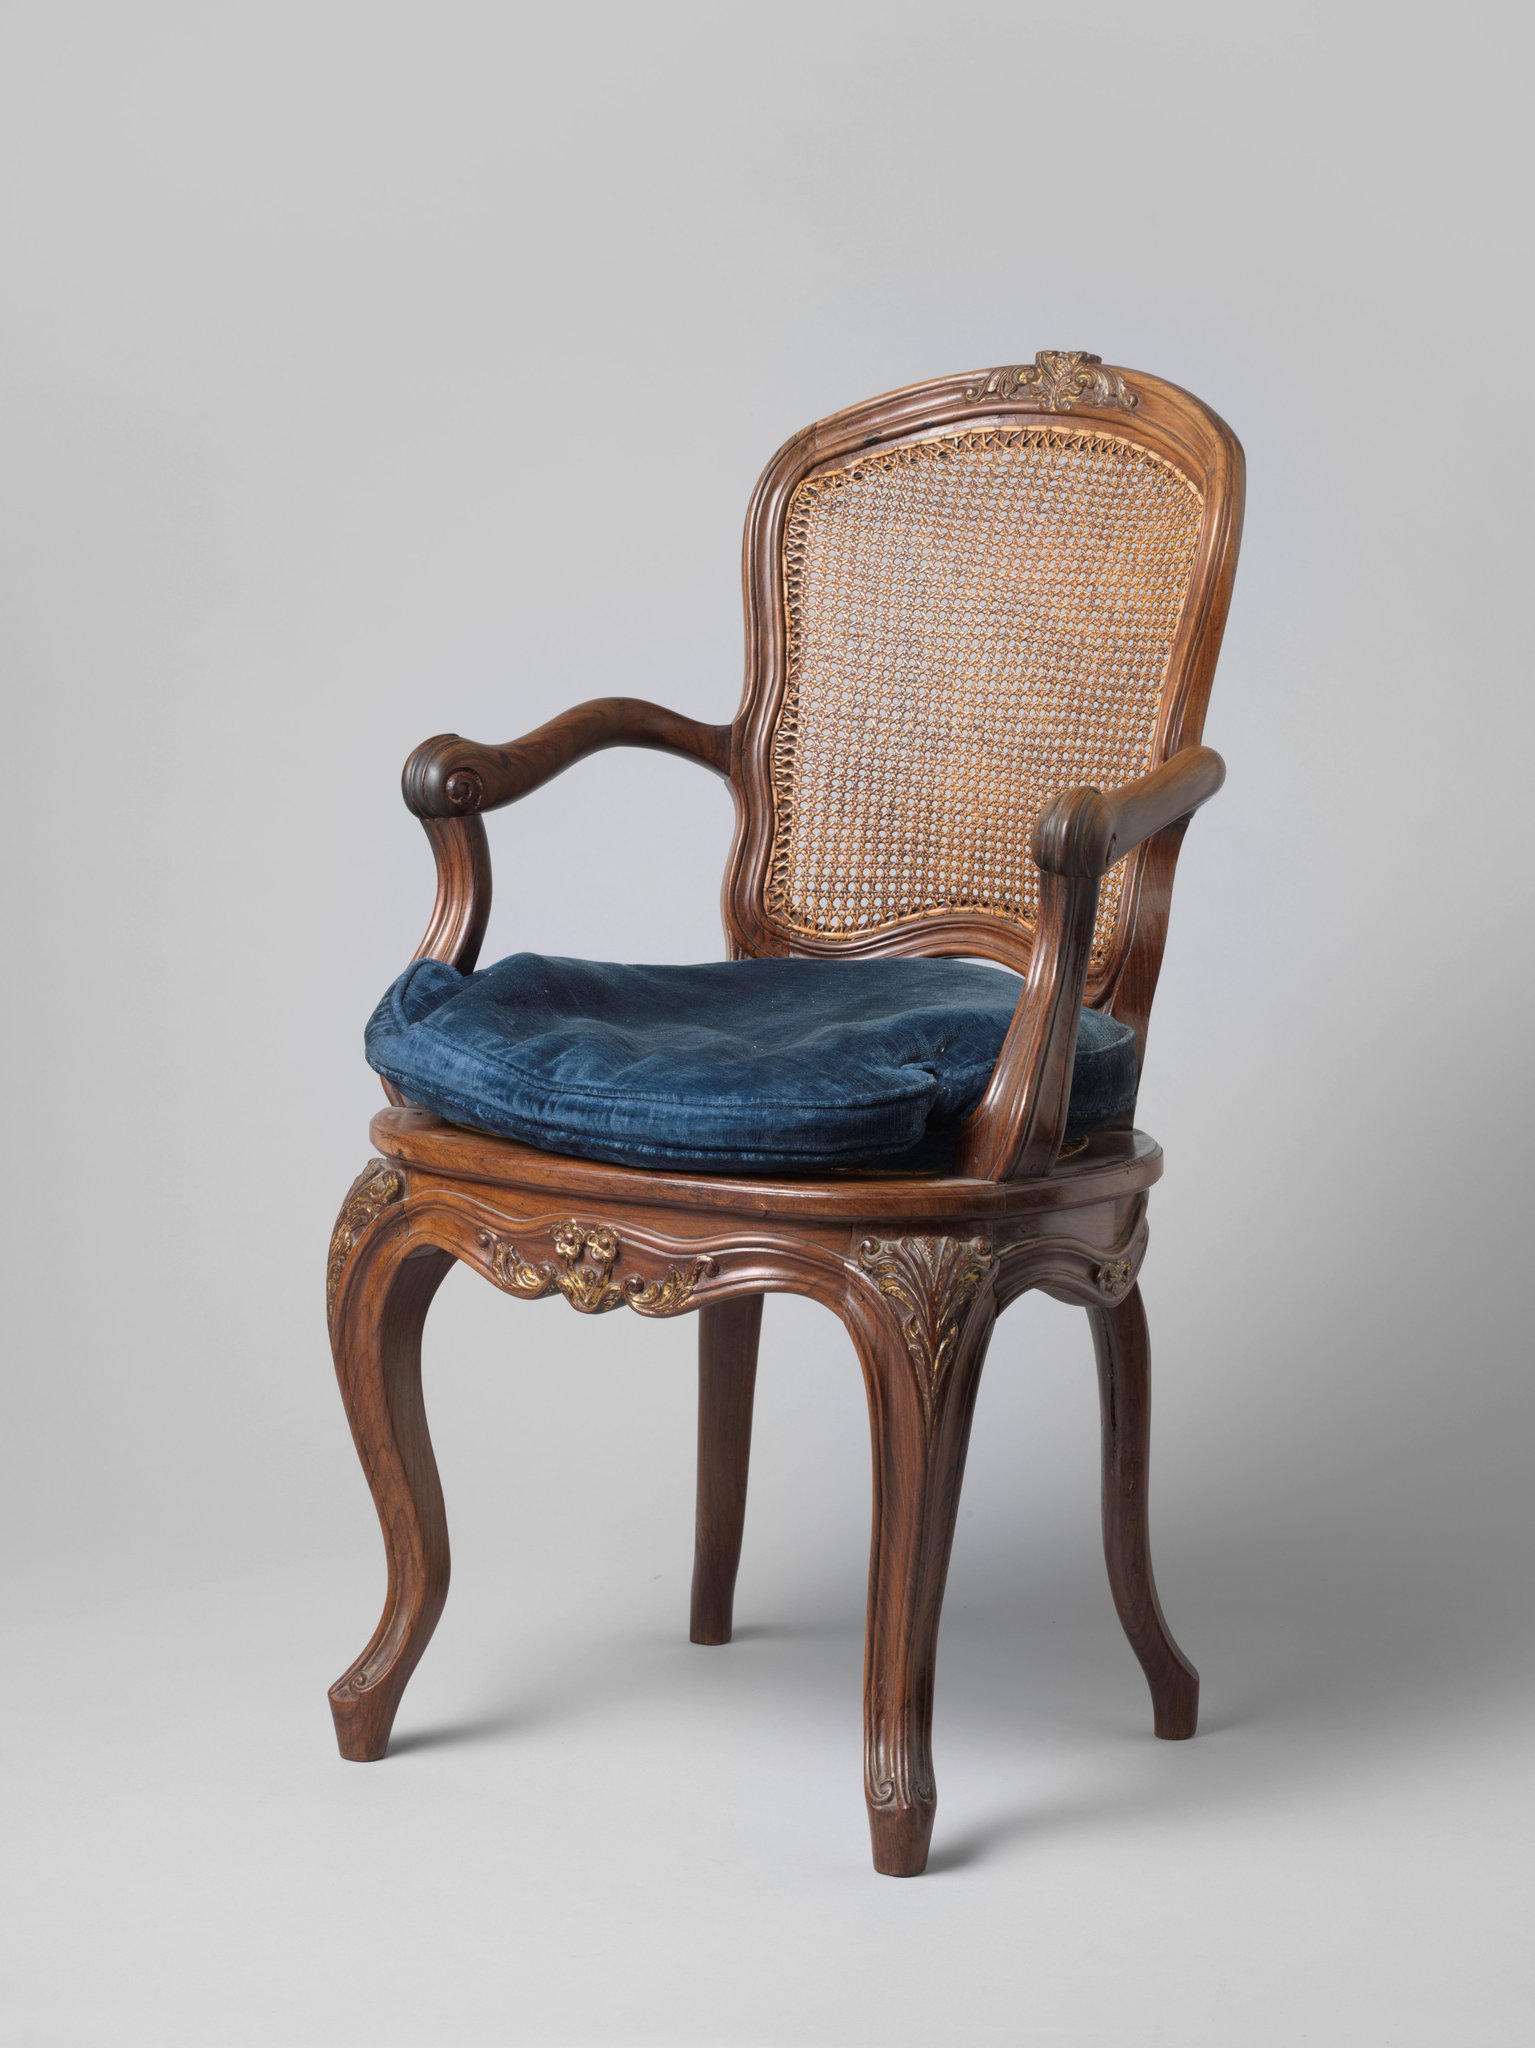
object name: armchair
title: koloniale armstoel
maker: Anonymous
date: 1700-1800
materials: rattan, velvet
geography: indonesia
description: Armstoel. Zitting met stof bekleed, rug met rotan. Een uit set van 6